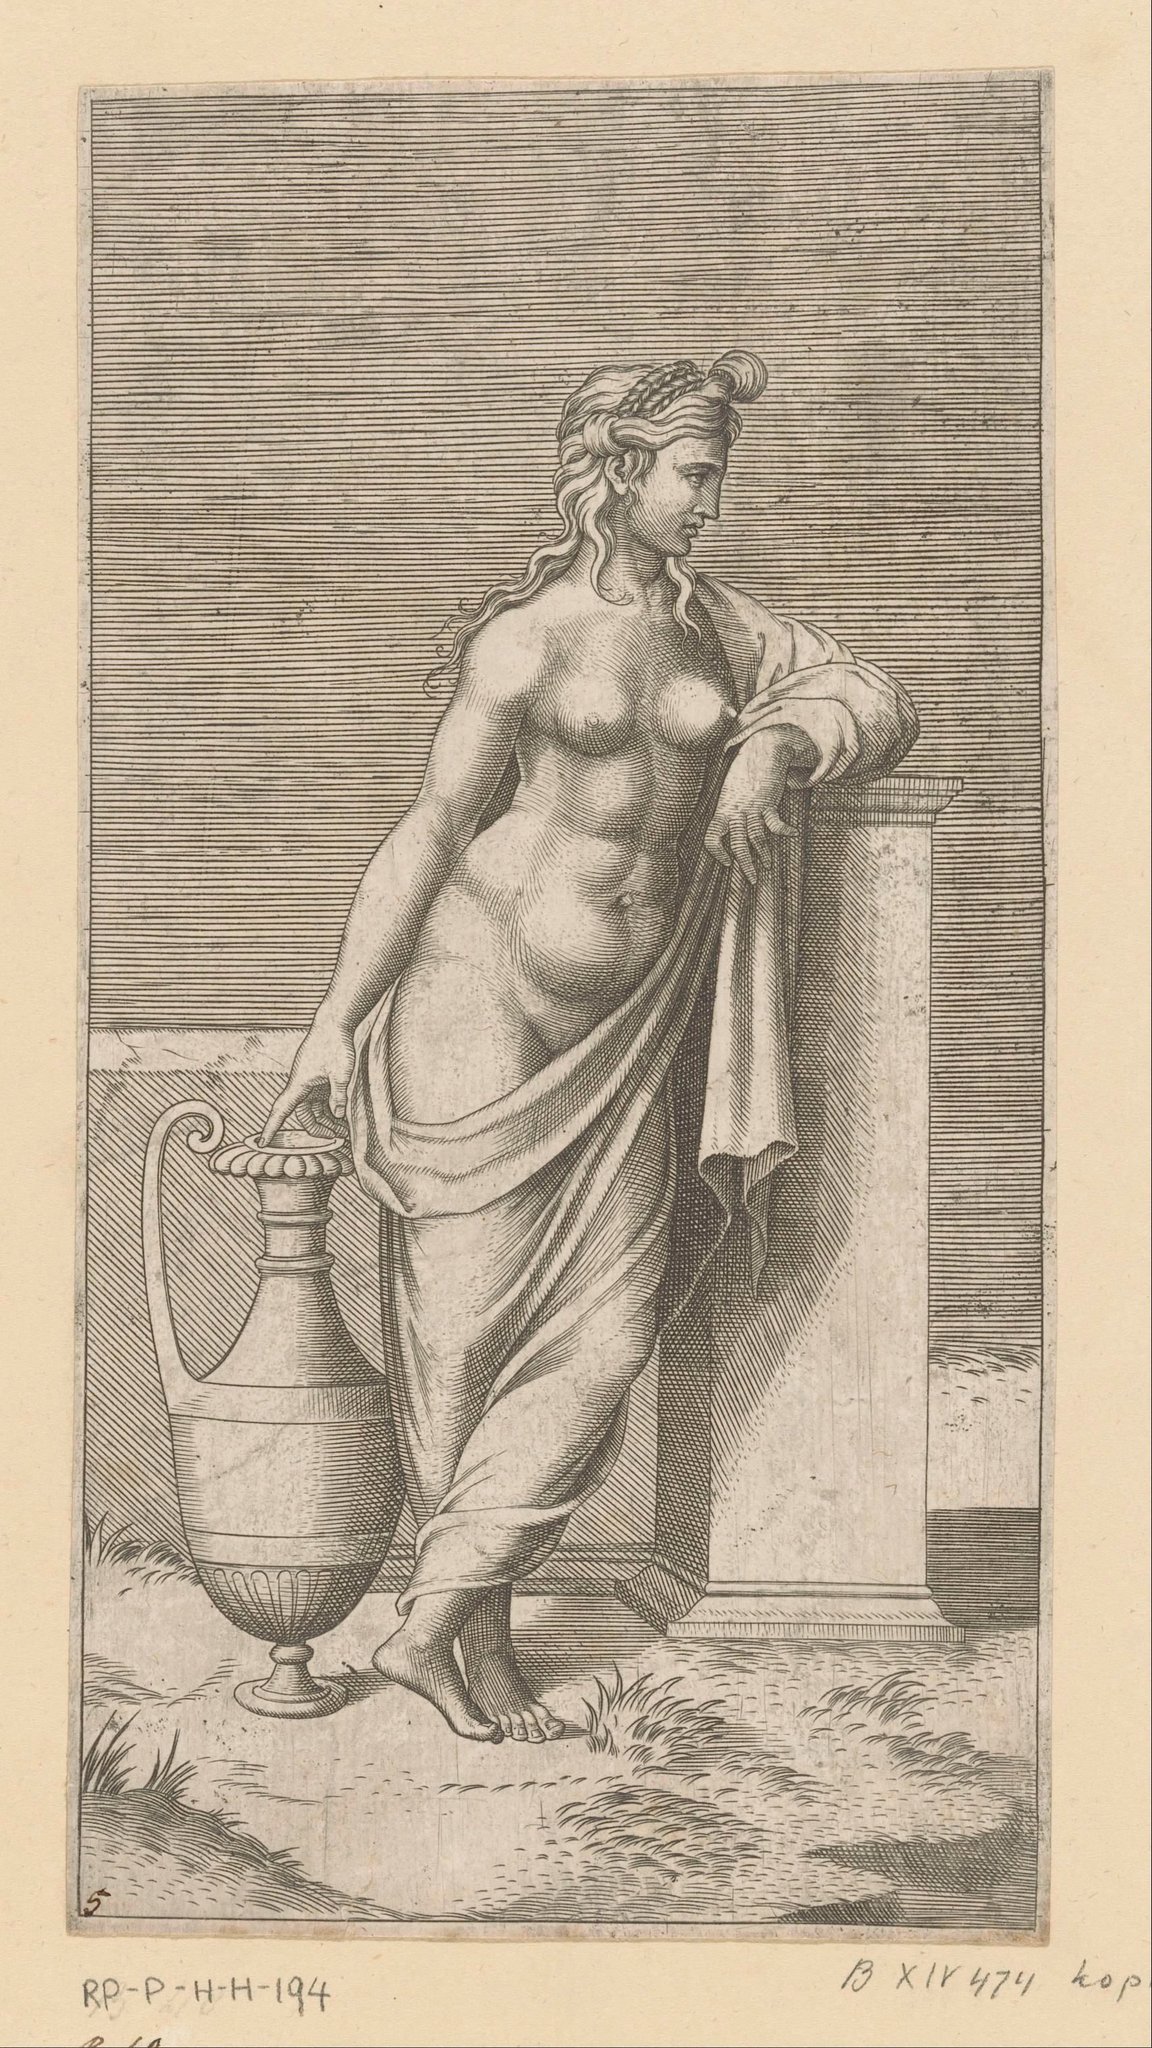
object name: print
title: Vrouw met amfoor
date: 1500-1536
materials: paper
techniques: engraving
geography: italy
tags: the (nude) human figure; 'corpo humano' (ripa), container of stone: stone vase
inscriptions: collector's mark: ‘Hinloopen’, number: ‘5’, collector's mark: Lugt 10, collector's mark: Lugt 11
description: Spiegelbeeldige kopie naar een prent van Agostino Veneziano, zonder landschap op de achtergrond. Een tekening met deze compositie, gevat in een architectonische omlijsting, bevindt zich in het Musée du Louvre te Parijs (inv.nr. 3585).